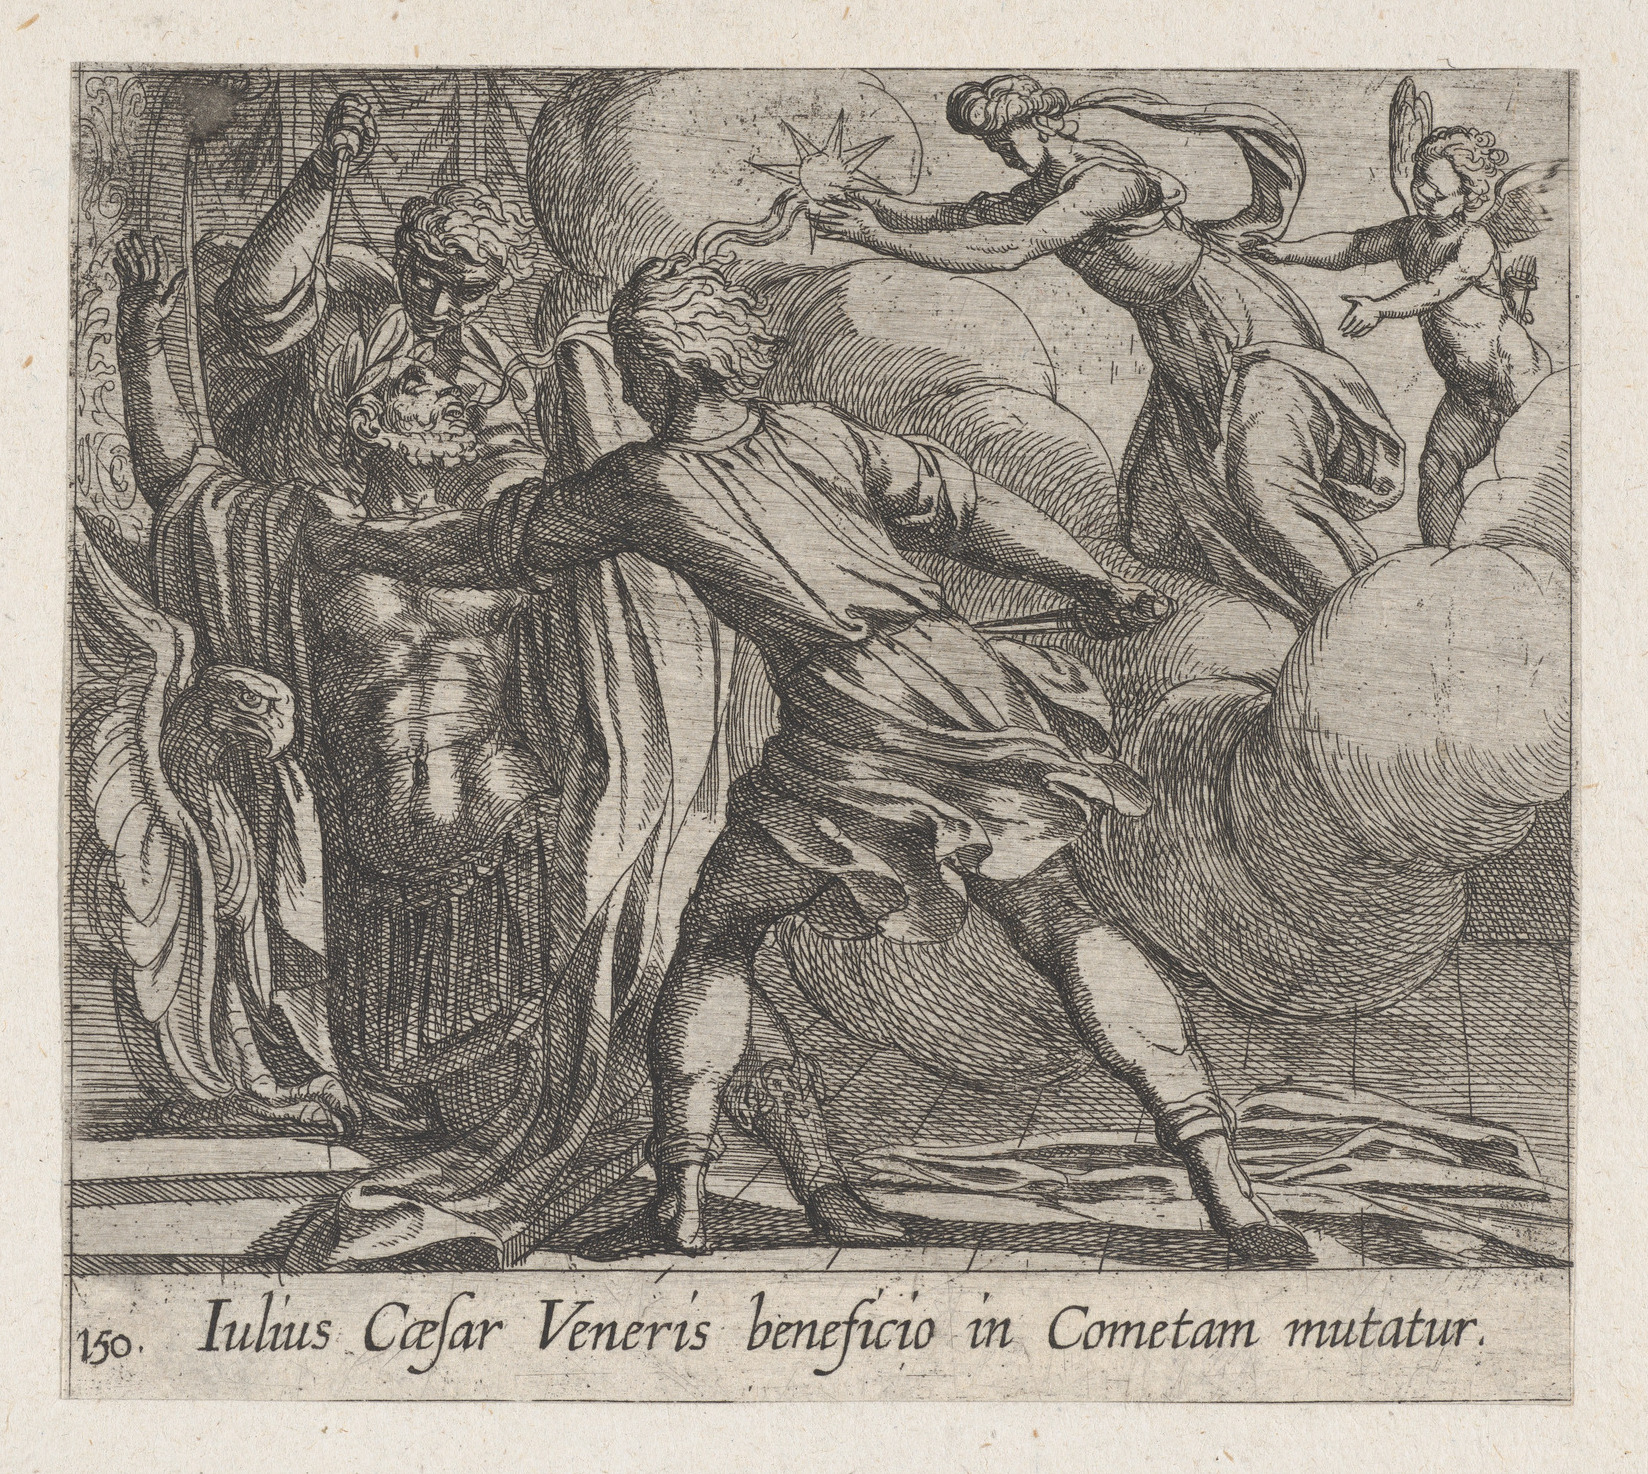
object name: print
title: The Murder of Julius Caesar (Iulius Caesar Veneris beneficio in Cometam mutatur), plate 150 from Ovid's "Metamorphoses"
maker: antonio tempesta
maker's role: artist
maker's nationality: italian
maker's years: 1555-1630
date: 1606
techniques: etching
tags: julius caesar,men,death